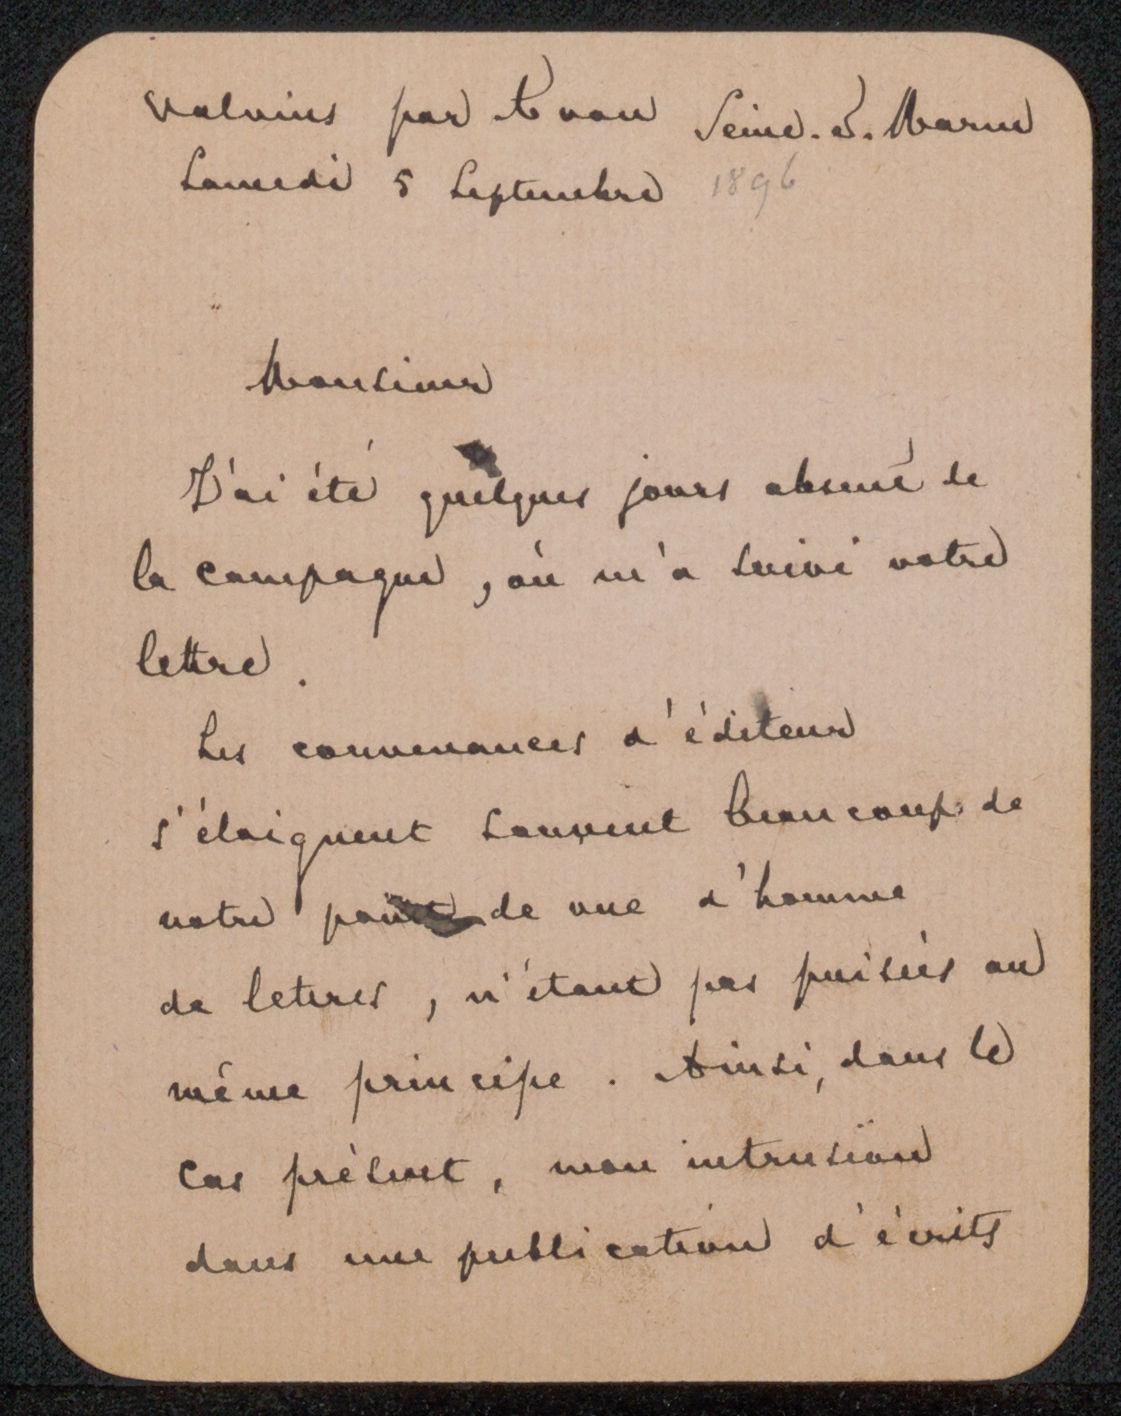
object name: letter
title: Brief aan Philip Zilcken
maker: stéphane mallarmé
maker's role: dichter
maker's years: 1842-1898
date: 1896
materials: cardboard, ink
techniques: pen, writing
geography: valvins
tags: paul verlaine, the hague, draughtsman, philip zilcken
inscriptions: collector's mark: ‘RPK’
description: Brief vormt samen met RP-D-1982-43-MALLARMÉ(S.)-2B een doorlopende brief.